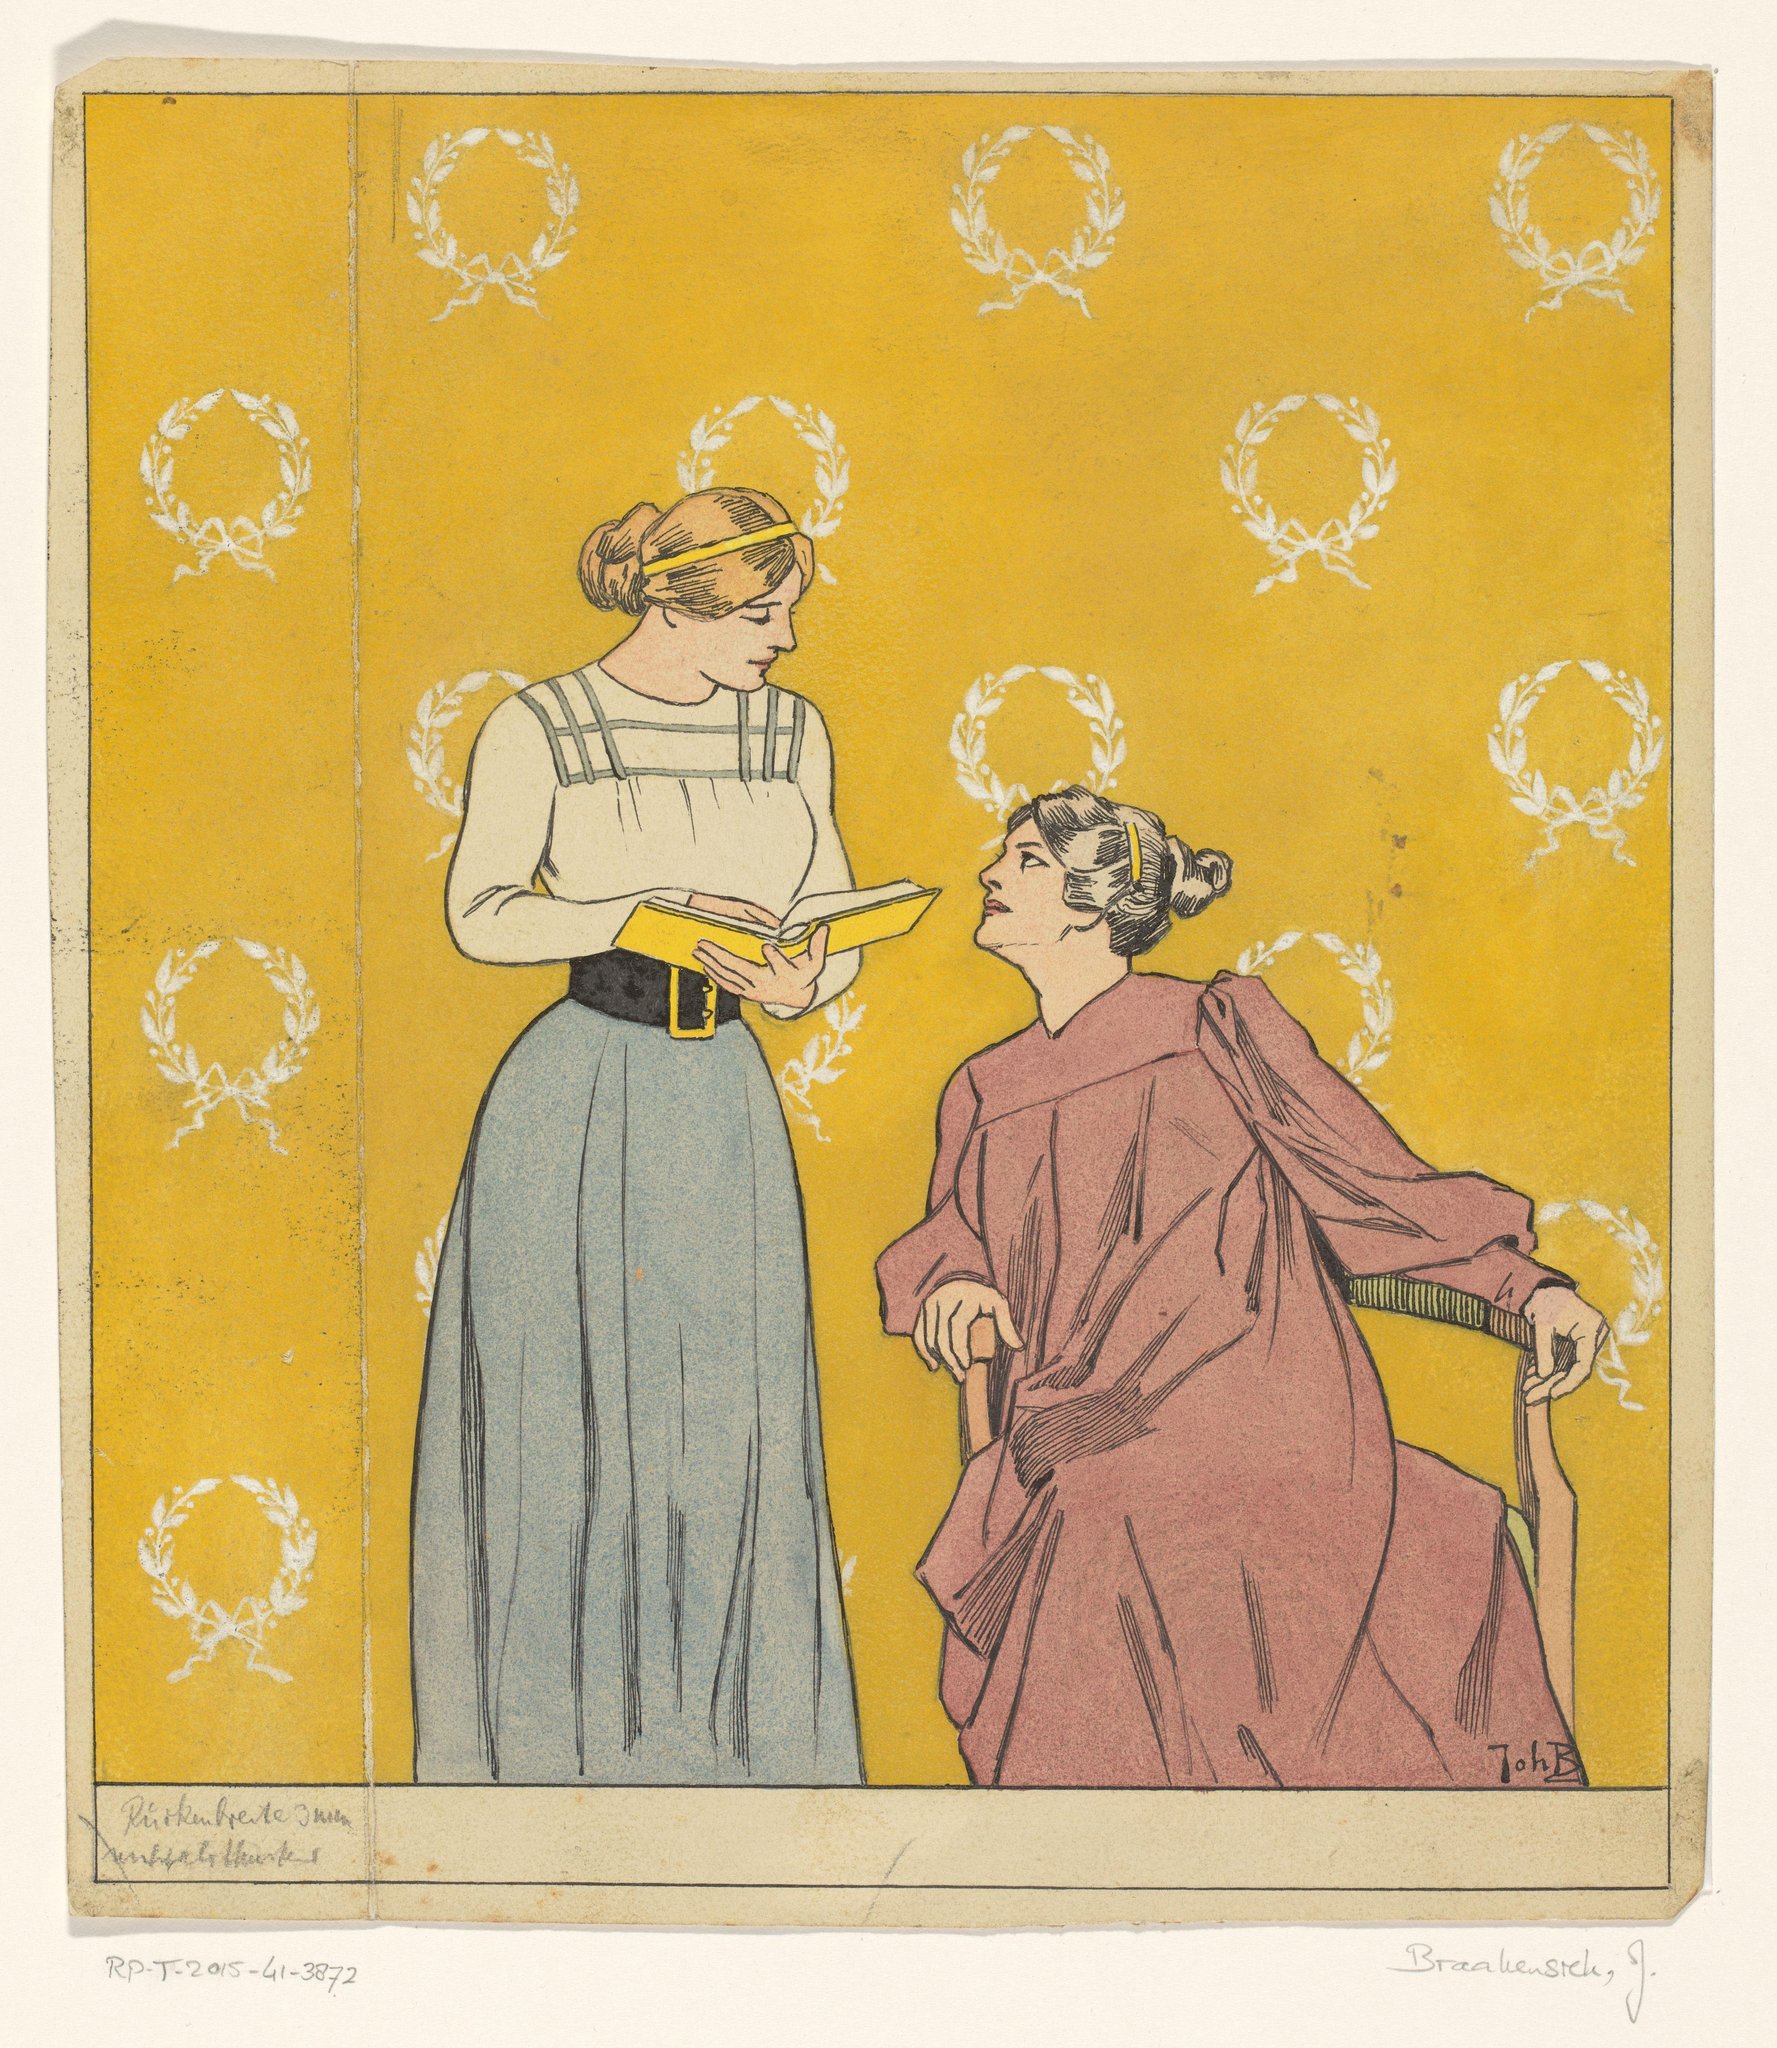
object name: study for binding design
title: Bandontwerp met twee vrouwen met een boek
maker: johan braakensiek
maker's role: draughtsman, print maker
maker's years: 1858-1940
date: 1868-1940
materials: paint, ink, paper, pencil, watercolor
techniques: brush, pen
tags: sitting figure - aa - female human figure, book - mm - book open, standing figure - aa - female human figure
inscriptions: :, collector's mark: Lugt 2228a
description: Staande vrouw met een open boek in haar handen naast een zittende vrouw die zich in haar richting keert. Op de achtergrond een decoratief motief met bladeren.